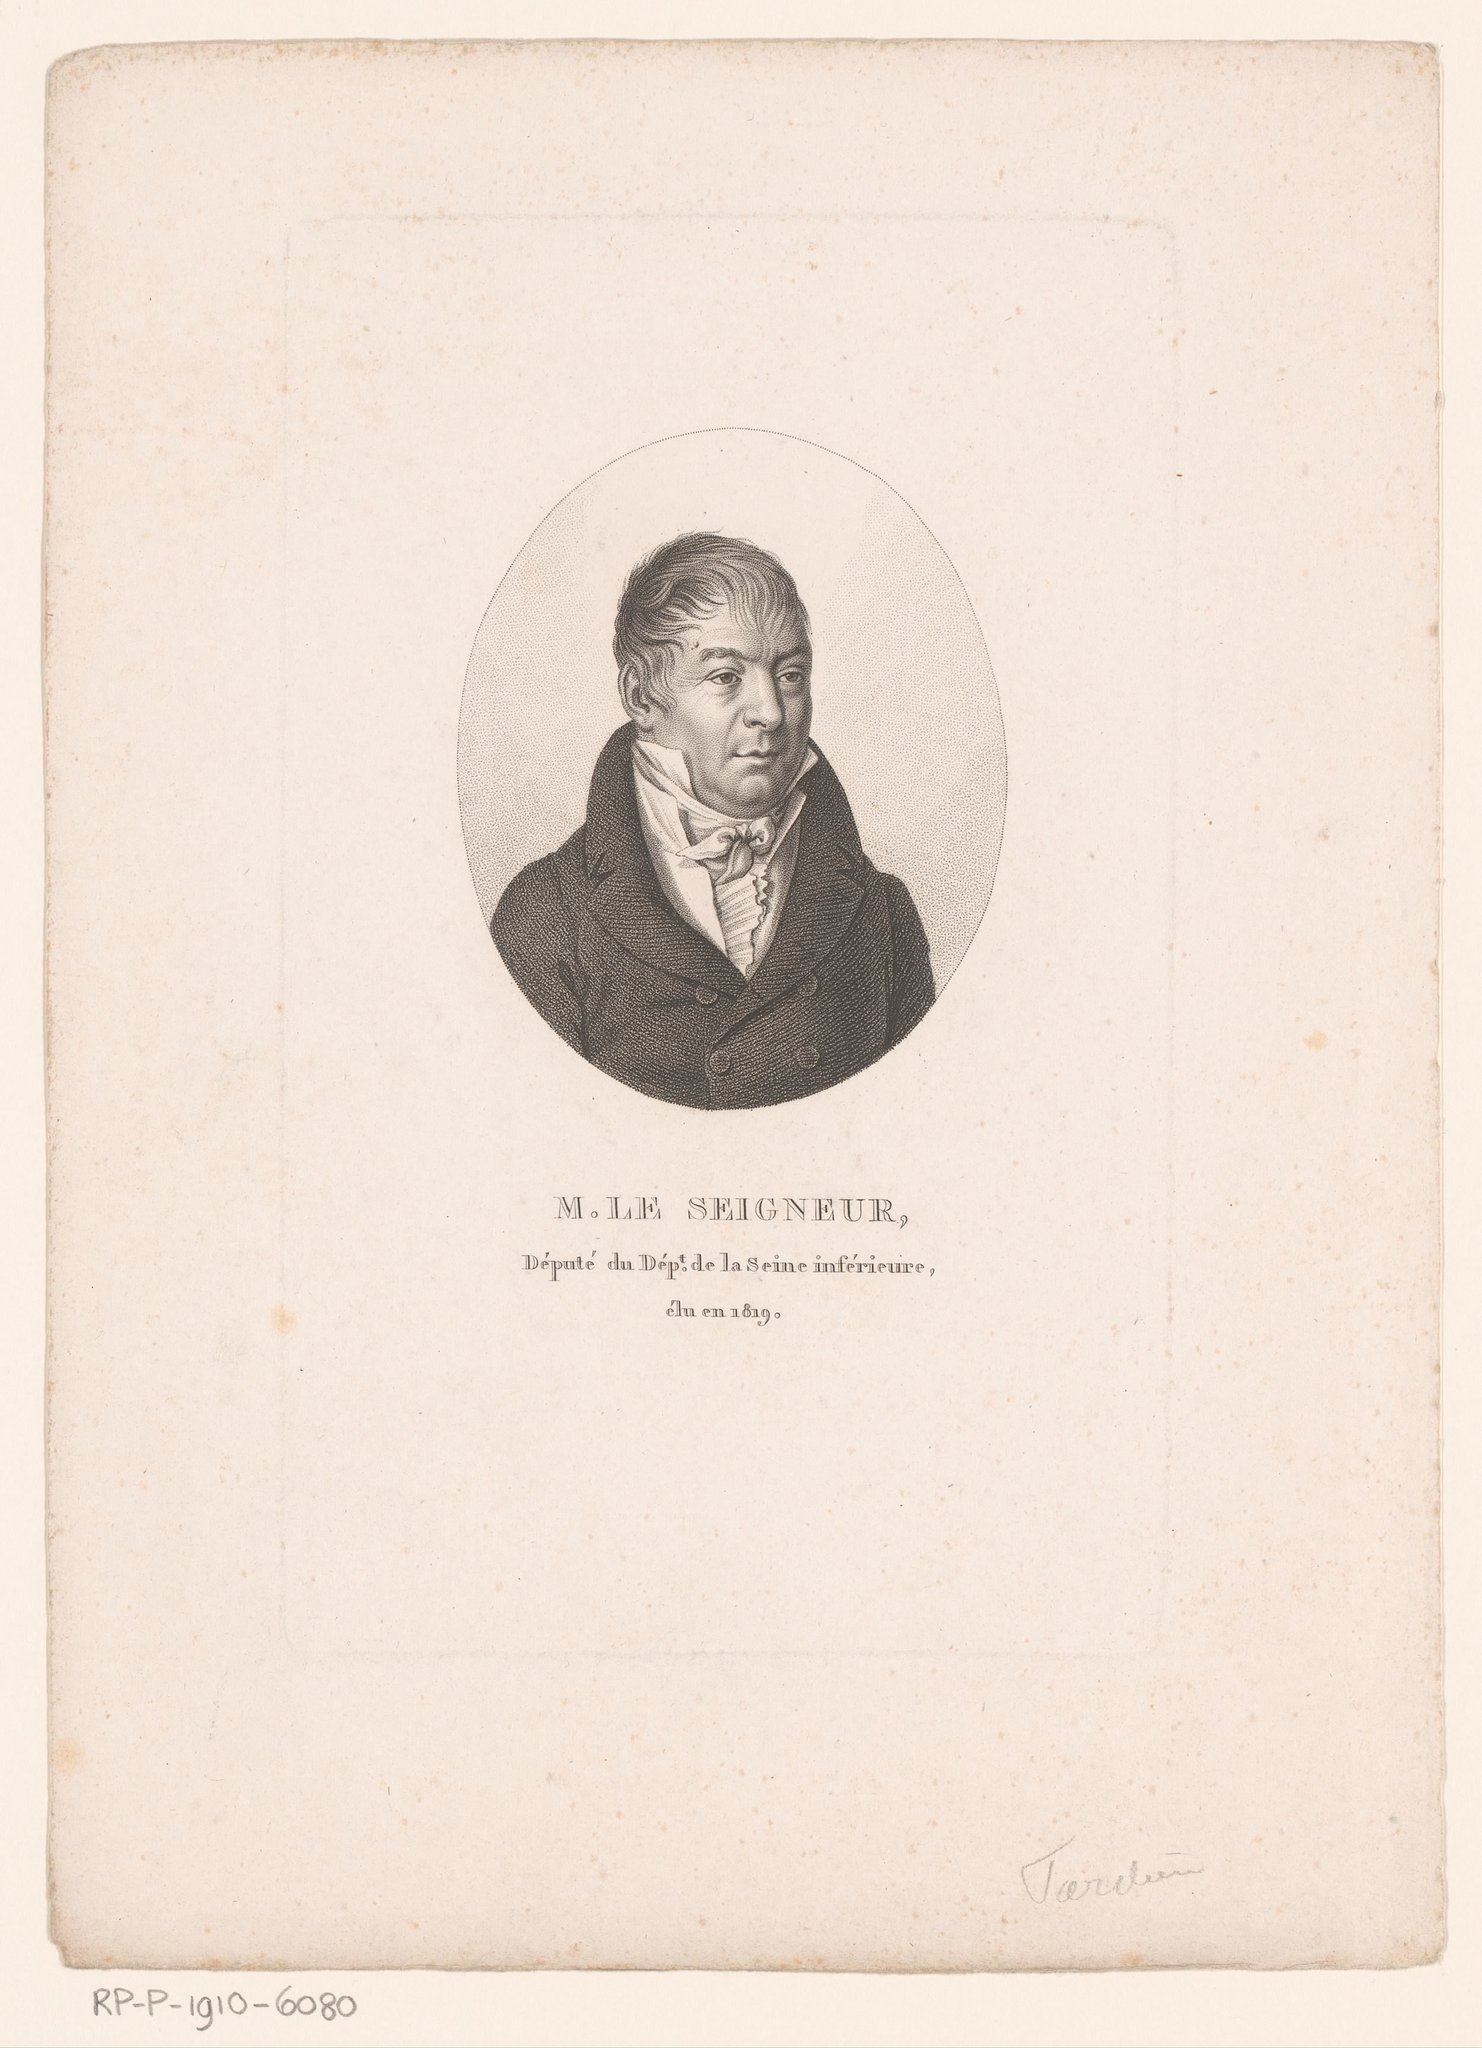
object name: book illustration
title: Portret van Abraham Leseigneur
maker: ambroise tardieu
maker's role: print maker, printer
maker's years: 1788-1841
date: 1820-1821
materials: paper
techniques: engraving, roulette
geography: paris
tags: historical persons, politician, e.g. party leader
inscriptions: collector's mark: Lugt 2228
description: Prent uit: Tardieu, Ambroise. Portraits des députés, écrivains et pairs constitutionnels, défenseurs invariables de la charte et de la loi des élections du 5 février 1817. Parijs: Tardieu, Ambroise, 1820-1821.